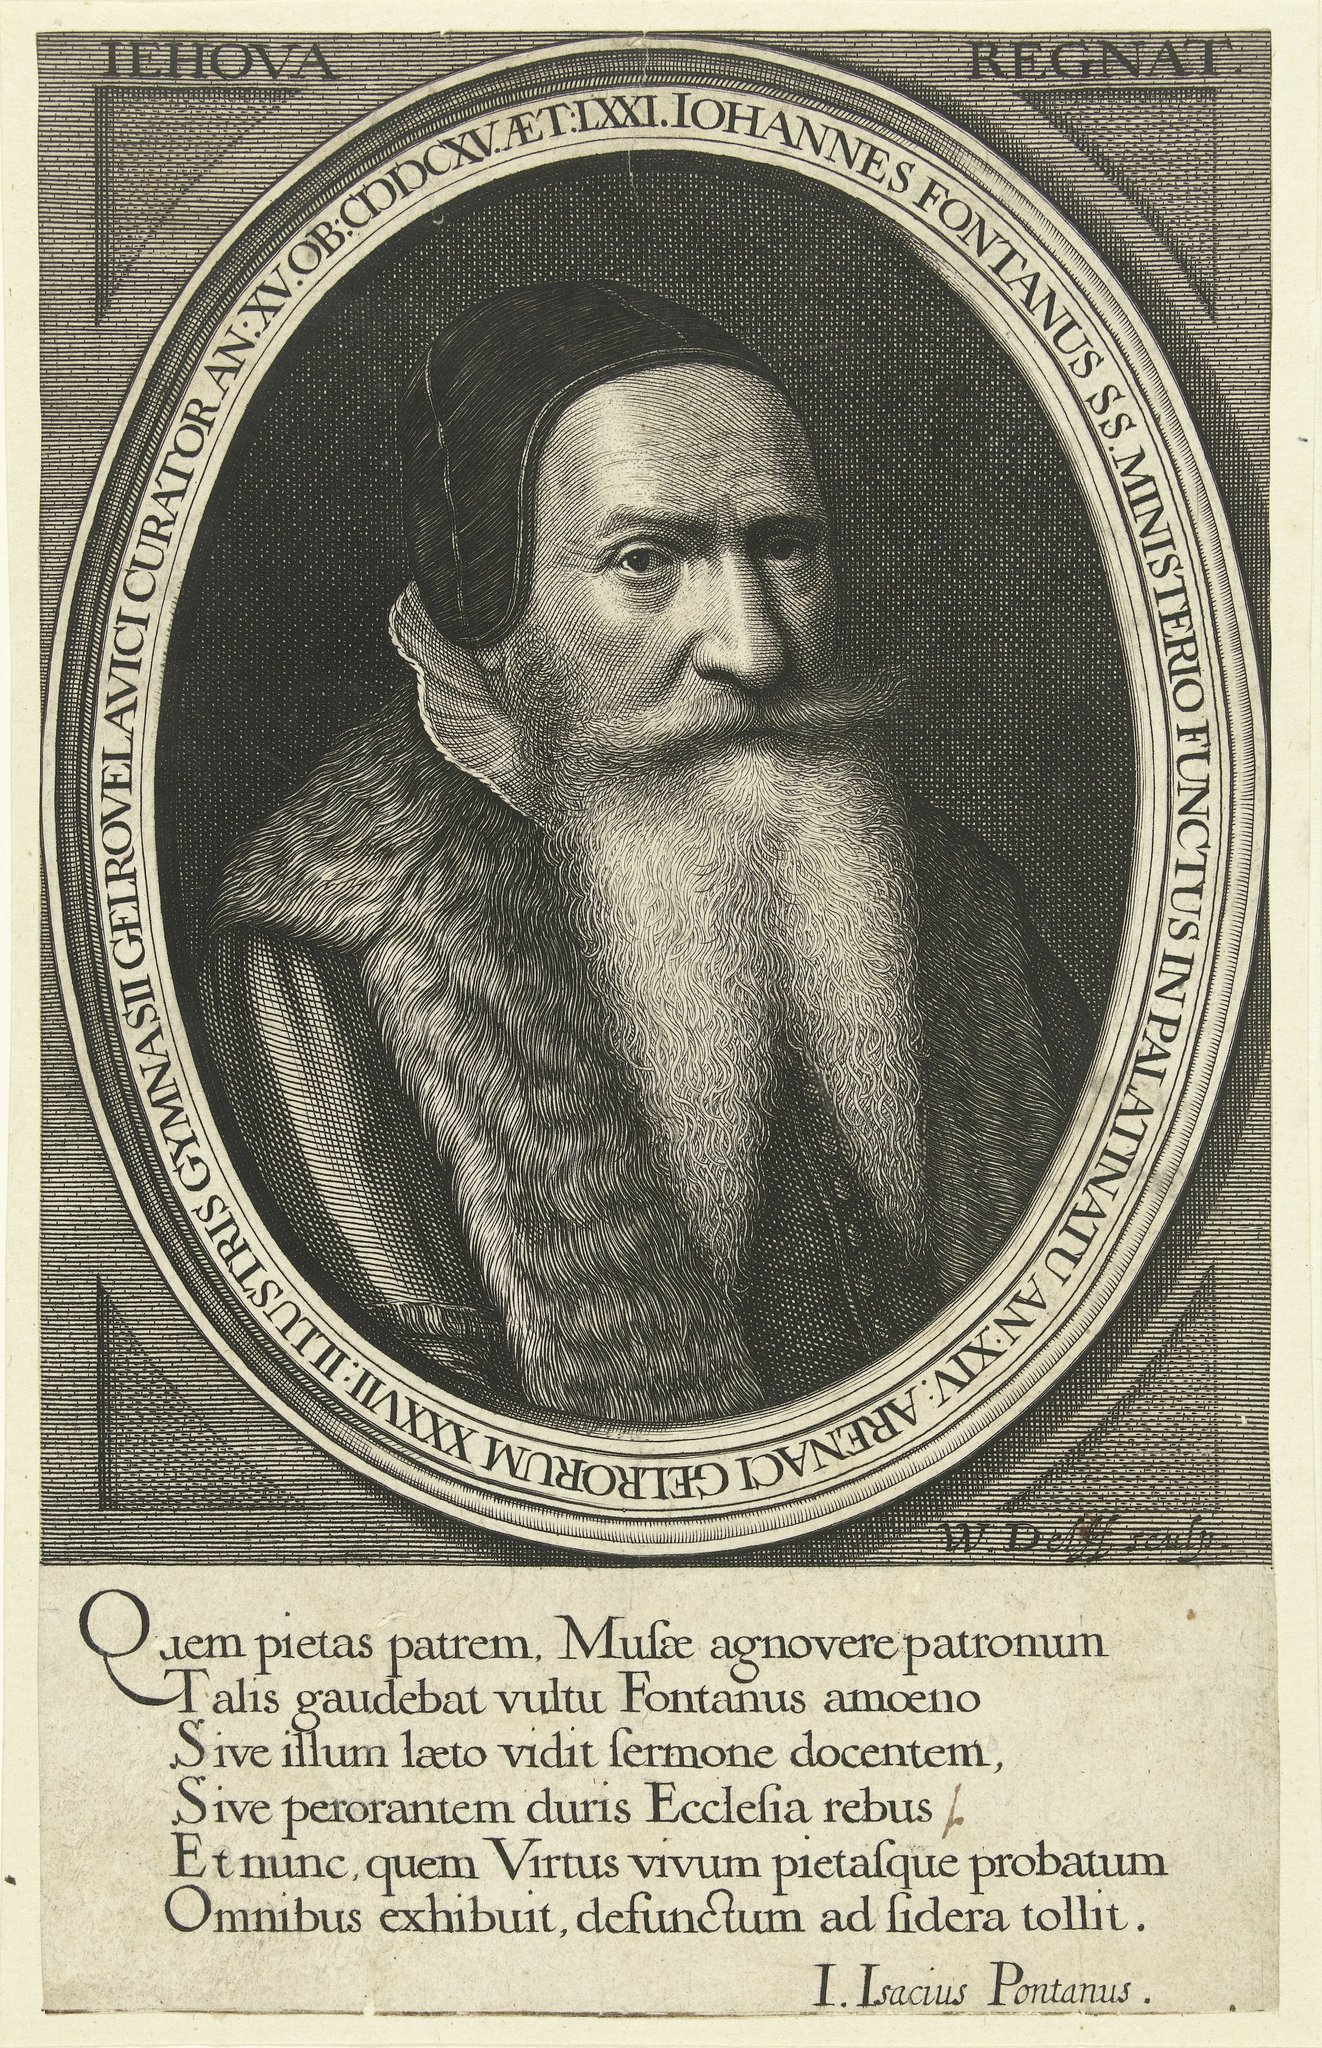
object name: print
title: Portret van theoloog Johannes Fontanus op 71-jarige leeftijd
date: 1615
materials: paper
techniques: engraving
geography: delft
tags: amsterdam, theologian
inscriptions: collector's mark: Lugt 2228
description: Portret van theoloog Johannes Fontanus op 71-jarige leeftijd, borststuk met lange baard en toga met bontkraag. Ovale omlijsting met Latijns opschrift, in ondermarge Latijns vers in zes regels.